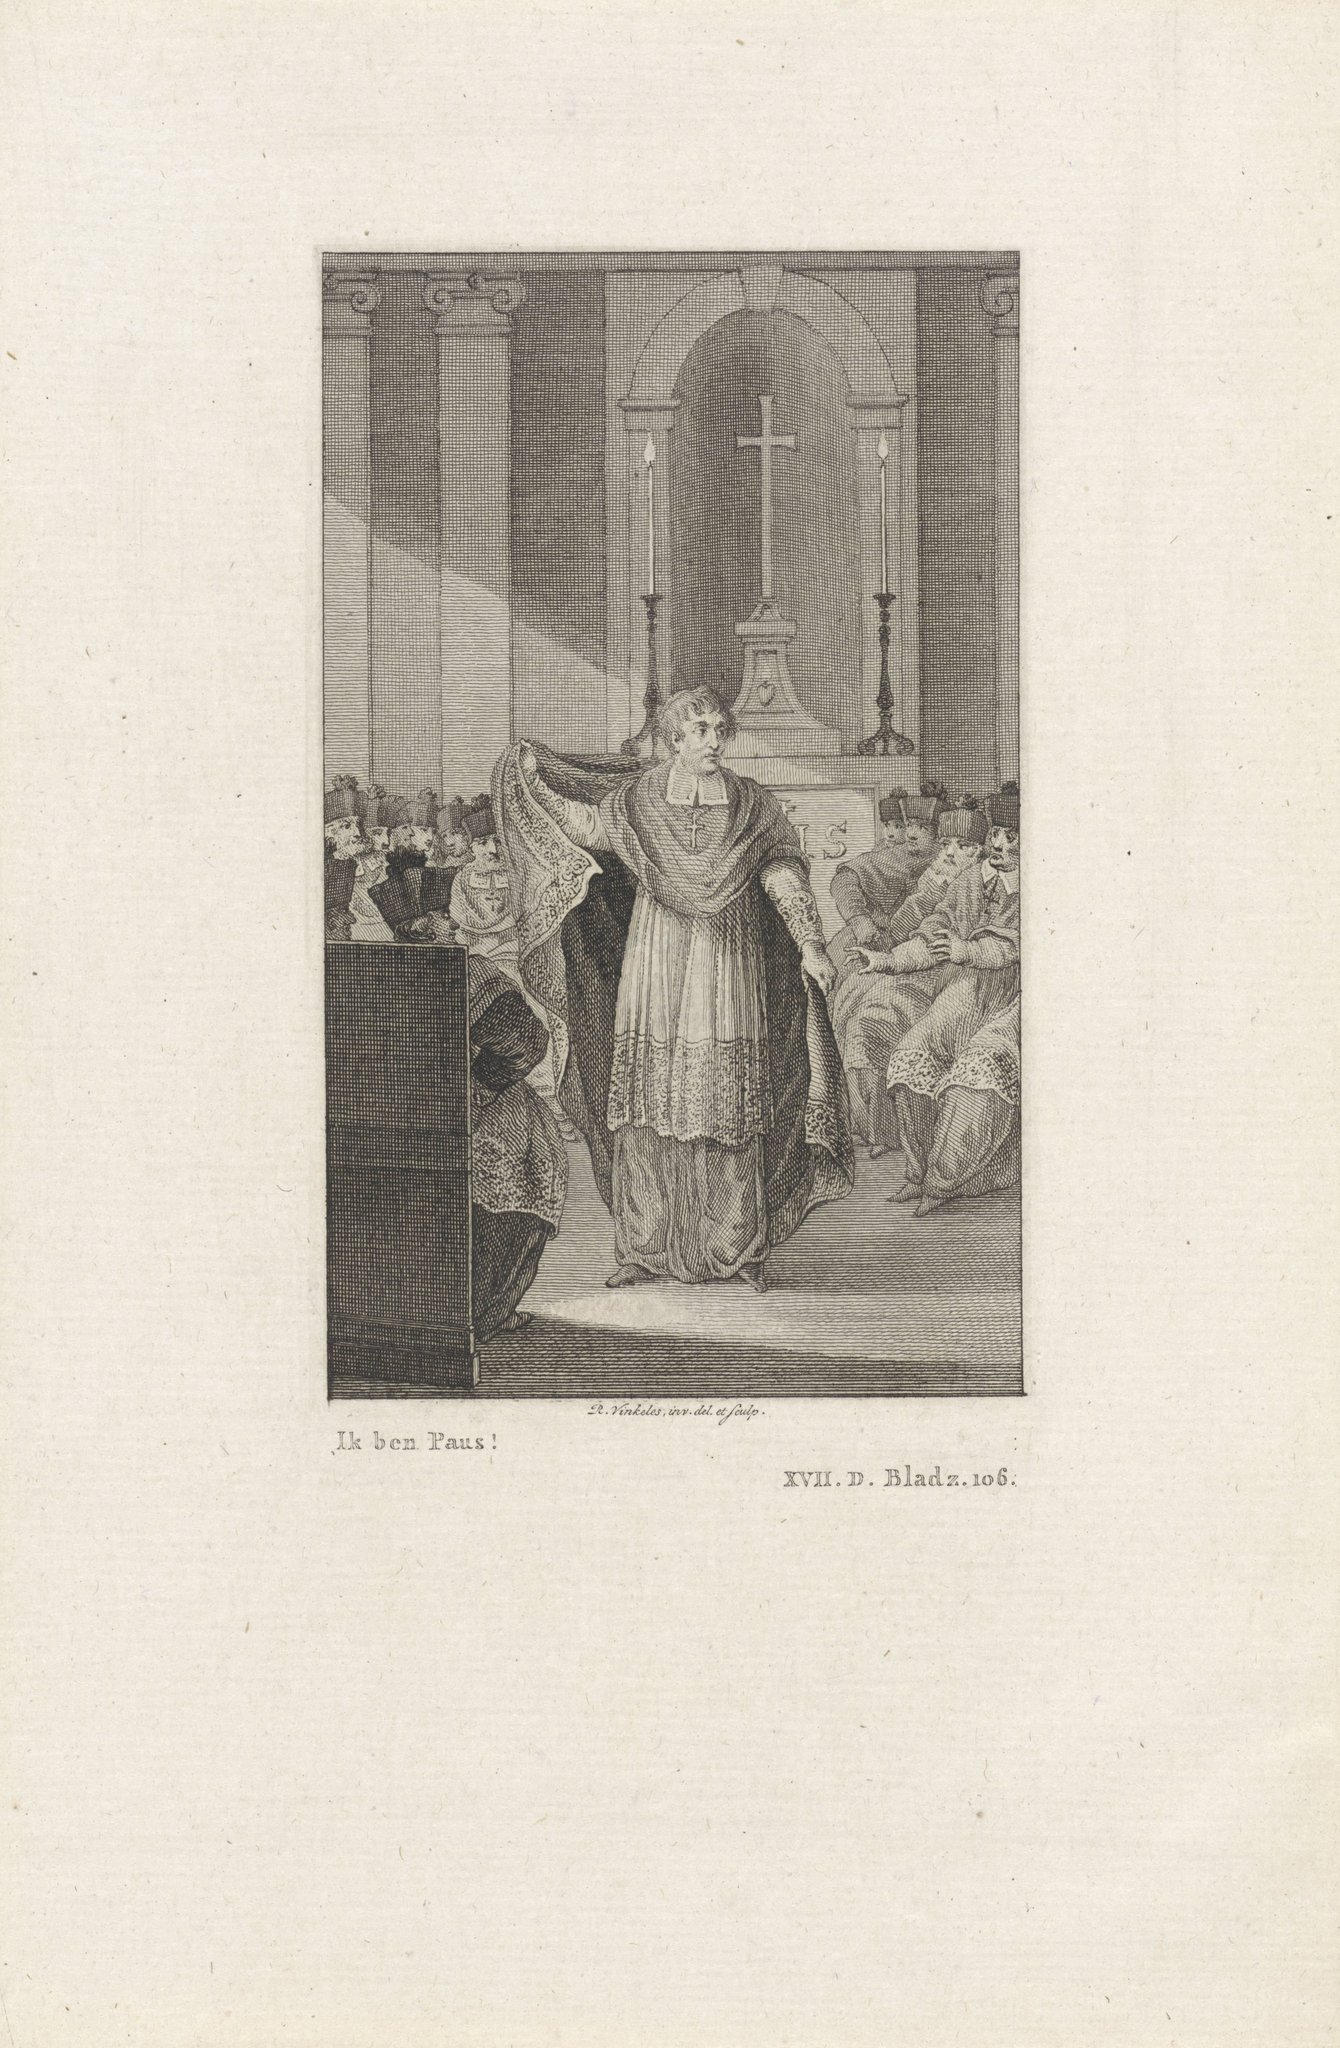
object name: print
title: Ik ben Paus!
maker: reinier vinkeles (i)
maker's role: draughtsman, print maker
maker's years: 1741-1816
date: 1808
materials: paper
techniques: engraving, etching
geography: amsterdam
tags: installation of a pope - pp - antipope, cardinal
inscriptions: collector's mark: Lugt 2228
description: Deze prent is ook gebruikt als illustratie in: Hamelsveld, Ysbrand van. Algemeene kerkelijke geschiedenis, der Christenen, deel 17. Haarlem: François Bohn, 1808, p. 106.